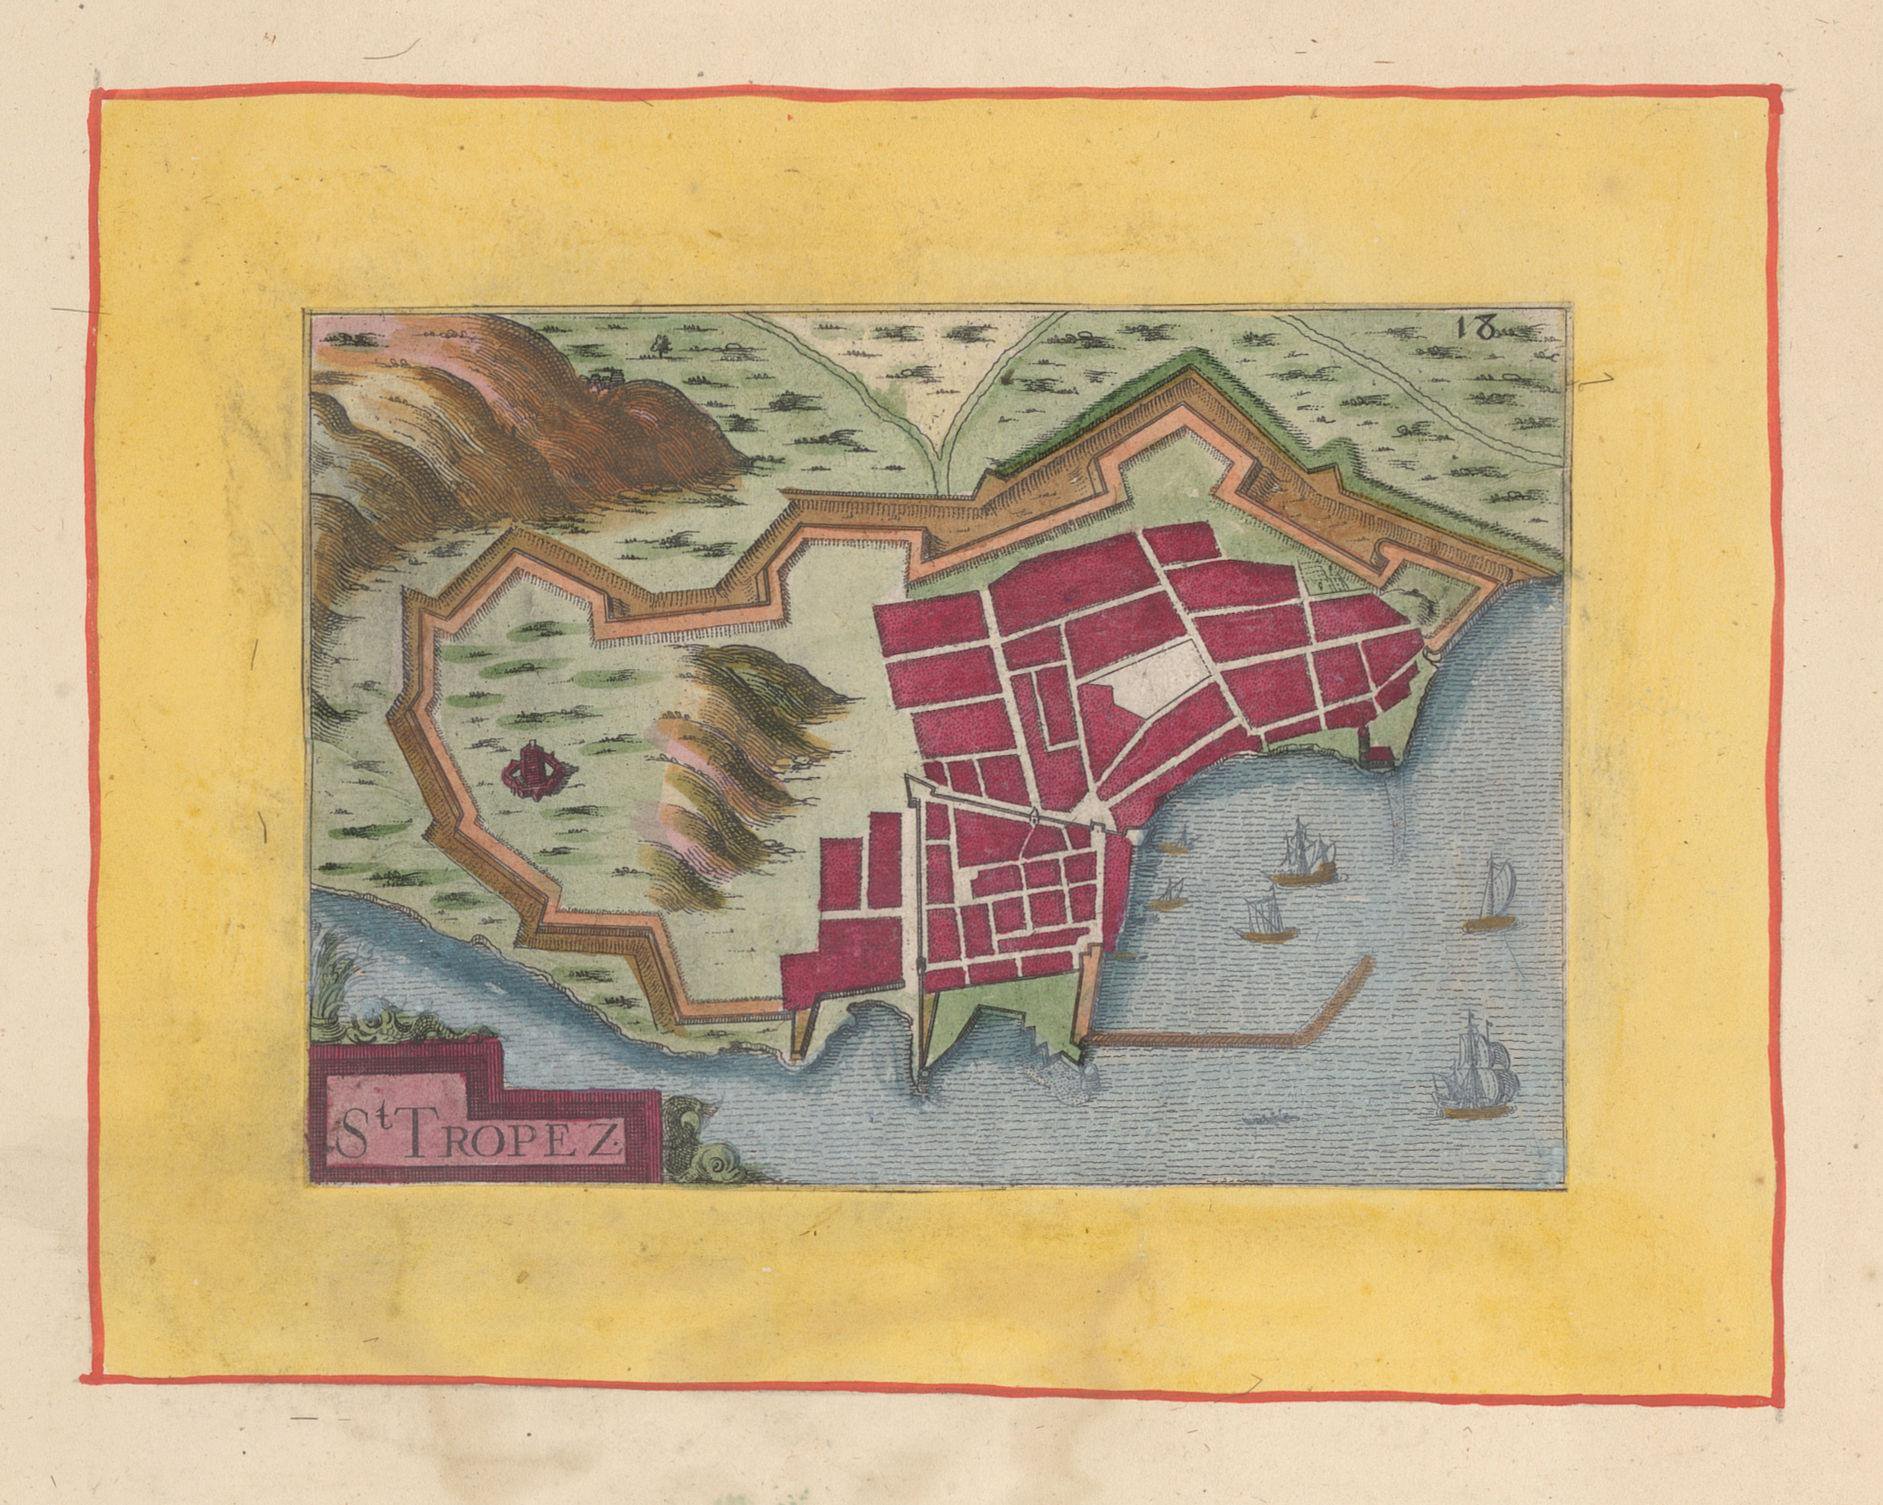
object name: area plan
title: Plattegrond van Saint-Tropez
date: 1638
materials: paper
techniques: engraving, etching, hand coloring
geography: paris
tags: maps of cities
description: Prent uit: Tassin, Christophe. Les plans et profils de toutes les principales villes et lieux considérables de France (...). Parijs: Michel van Lochom, 1638, kaart 18 uit het deel 'Provence'.